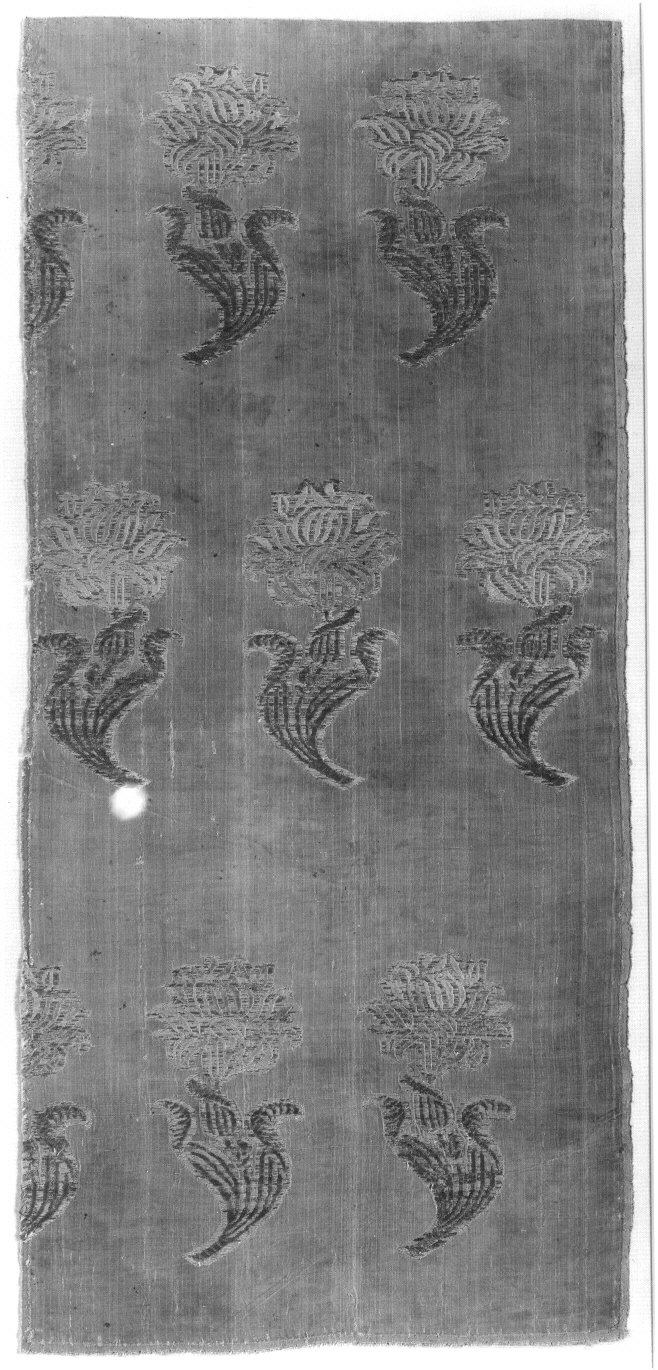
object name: textile fragment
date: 1601-1700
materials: metal thread, silk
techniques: brocade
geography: iran